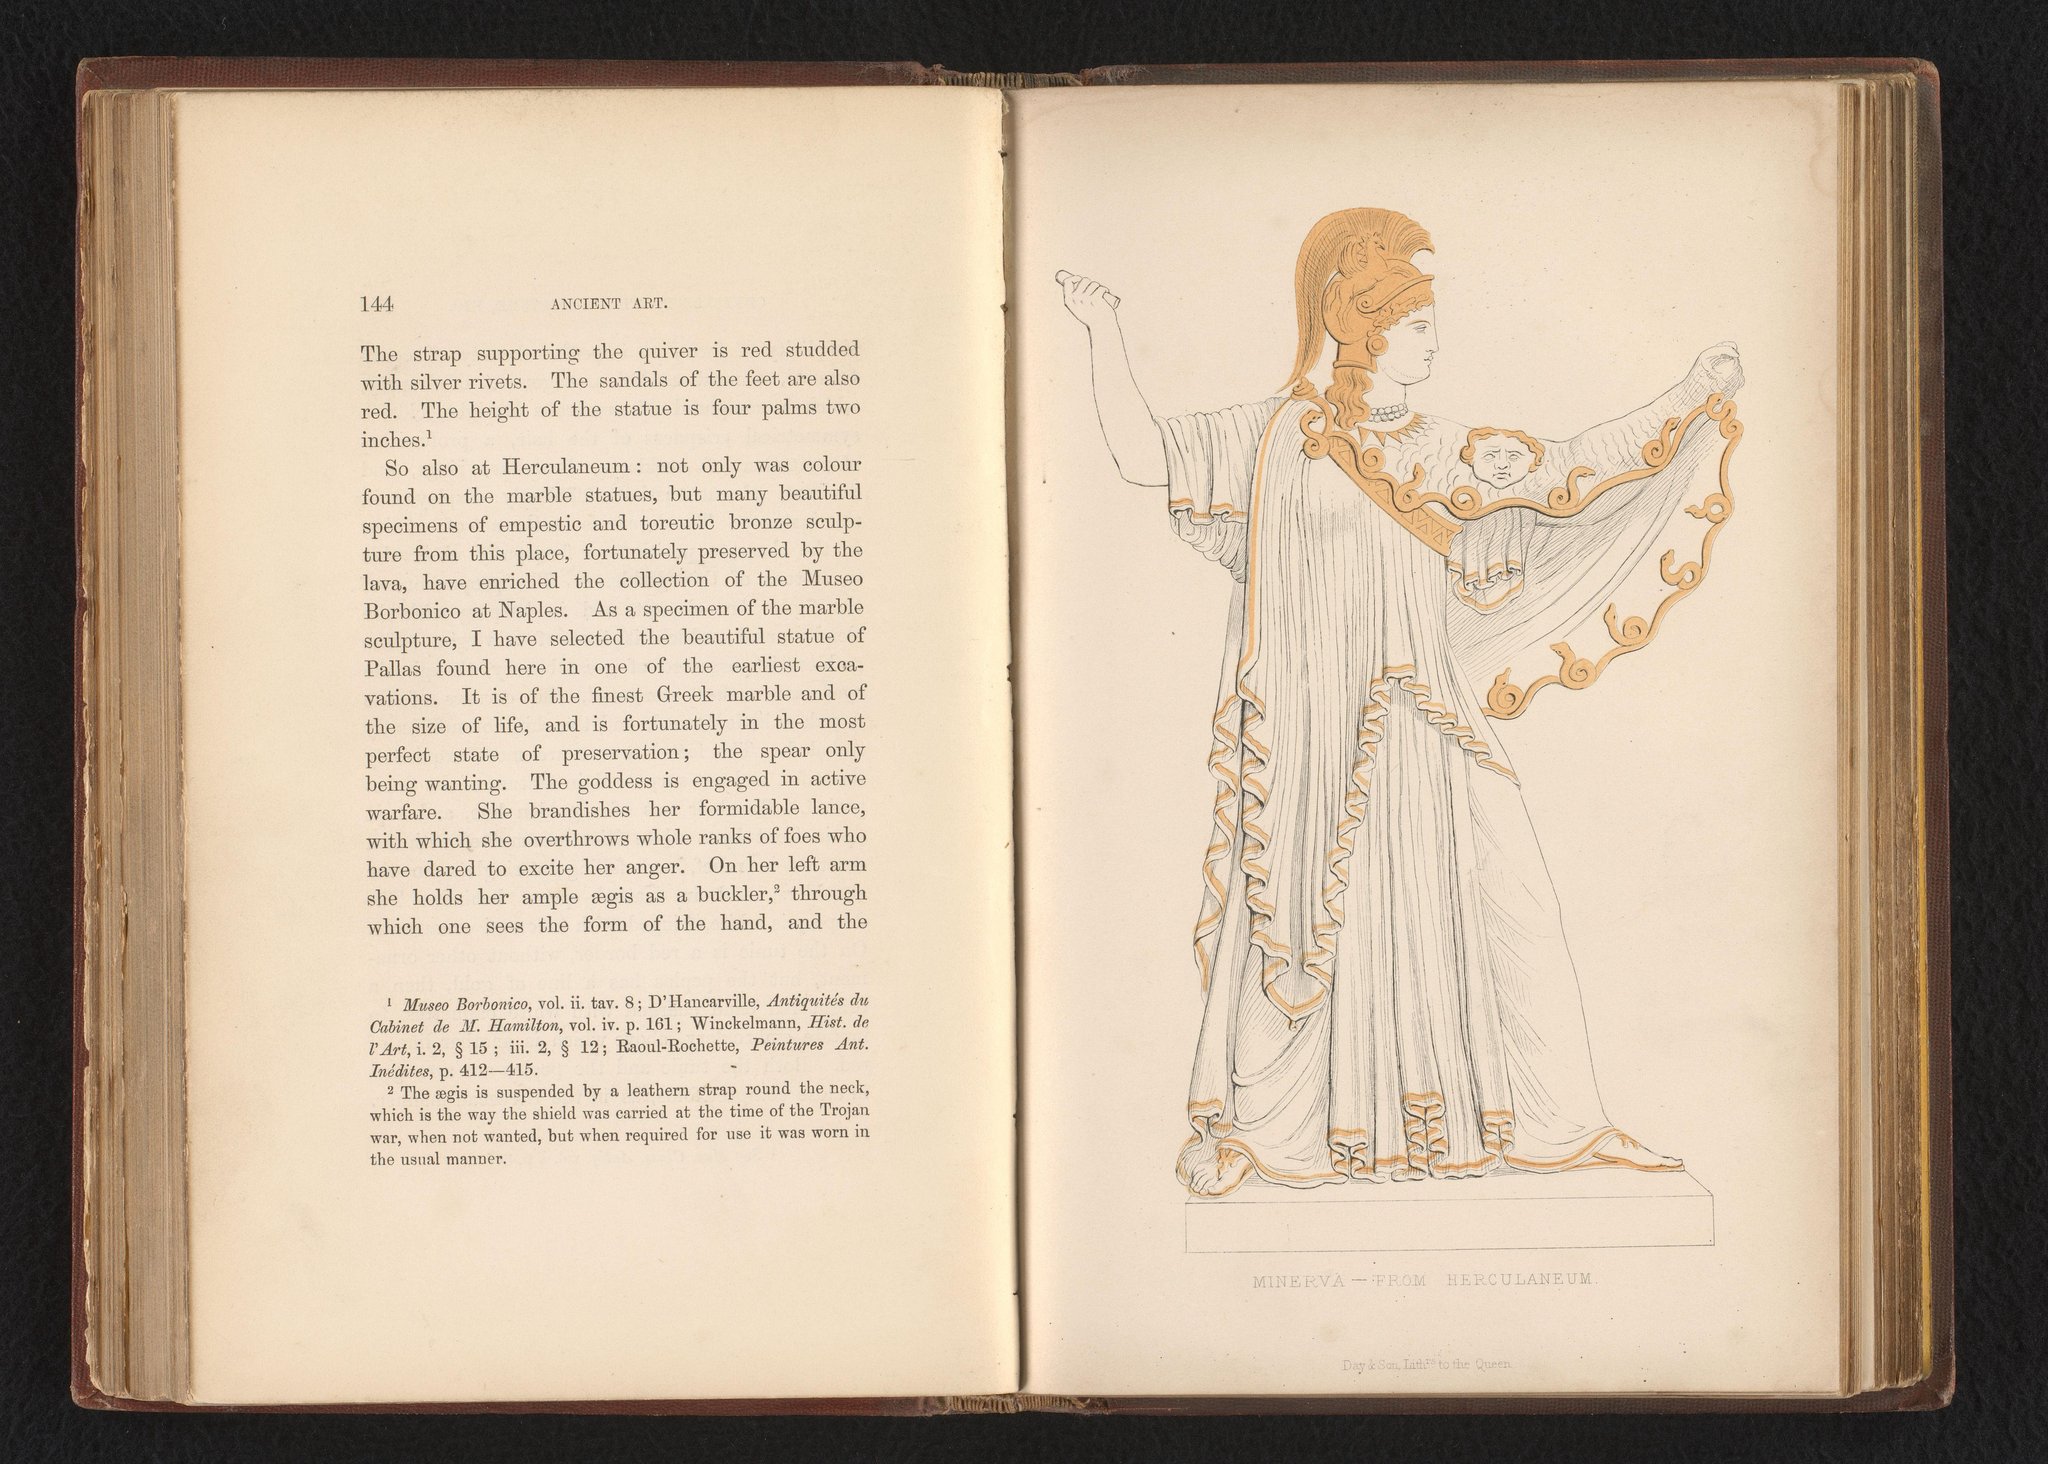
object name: page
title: Minerva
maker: Anonymous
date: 1855-1860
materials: paper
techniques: lithograph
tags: (story of) minerva (pallas, athena)